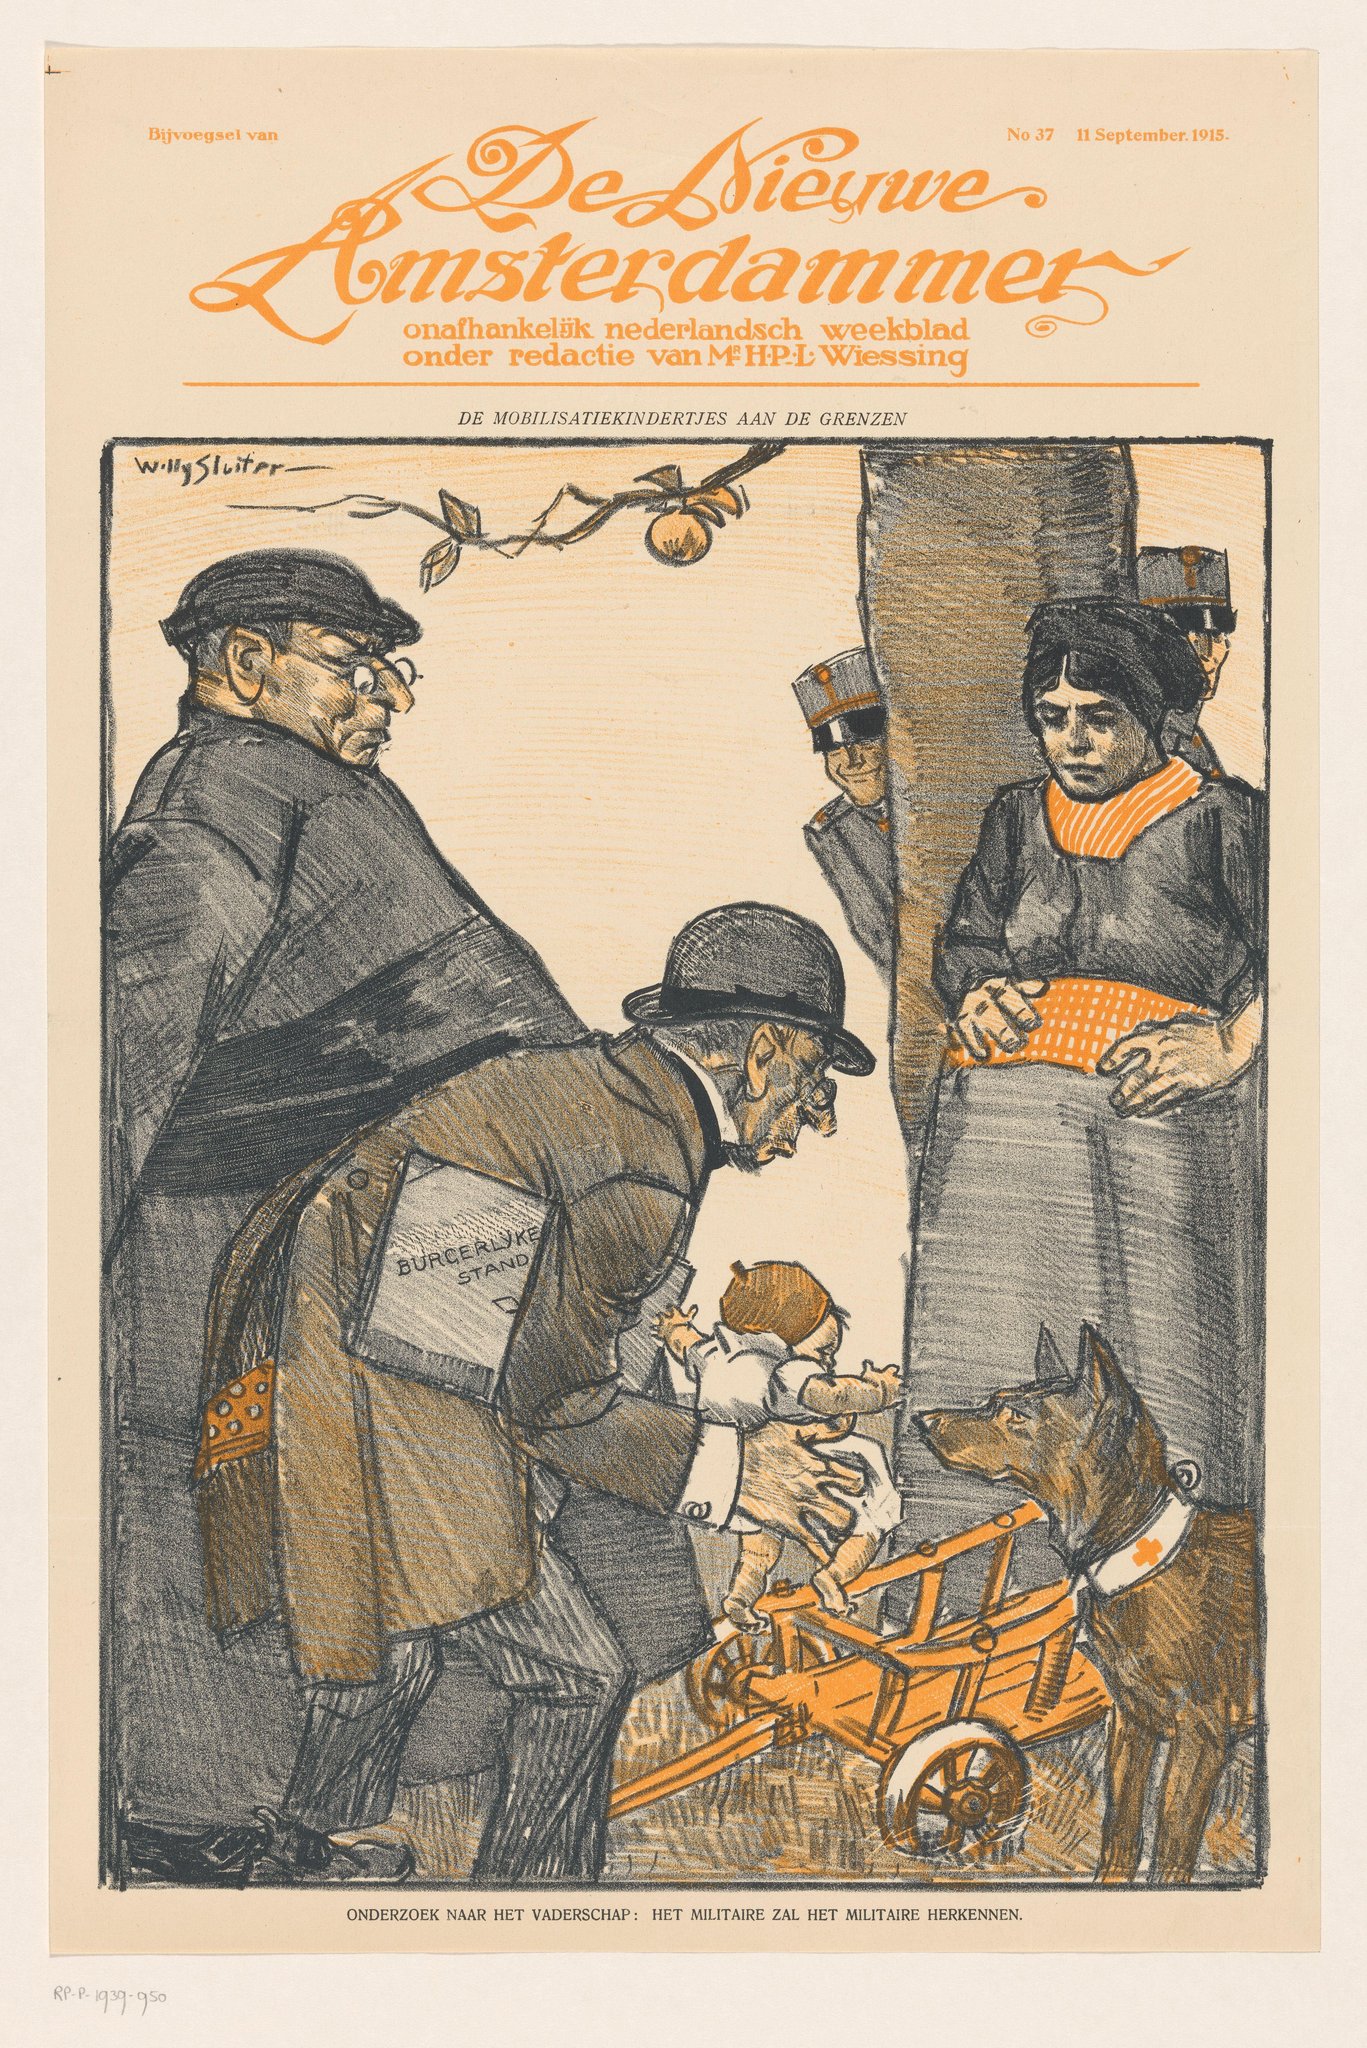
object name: cartoon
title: De mobilisatiekindertjes aan de grenzen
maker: willy sluiter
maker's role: draughtsman, painter, print maker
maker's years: 1873-1949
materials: paper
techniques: letterpress printing, lithograph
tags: mobilization of troops; call to arms, infant, baby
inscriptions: collector's mark: Lugt 2760, collector's mark: Lugt 2228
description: Een man van de burgerlijke stand tilt een baby op en houdt het kind voor een hond. Een vrouw en twee militairen achter een boom staan toe te kijken. Onder de voorstelling het opschrift: 'Onderzoek naar het vaderschap: het militaire zal het militaire herkennen.'